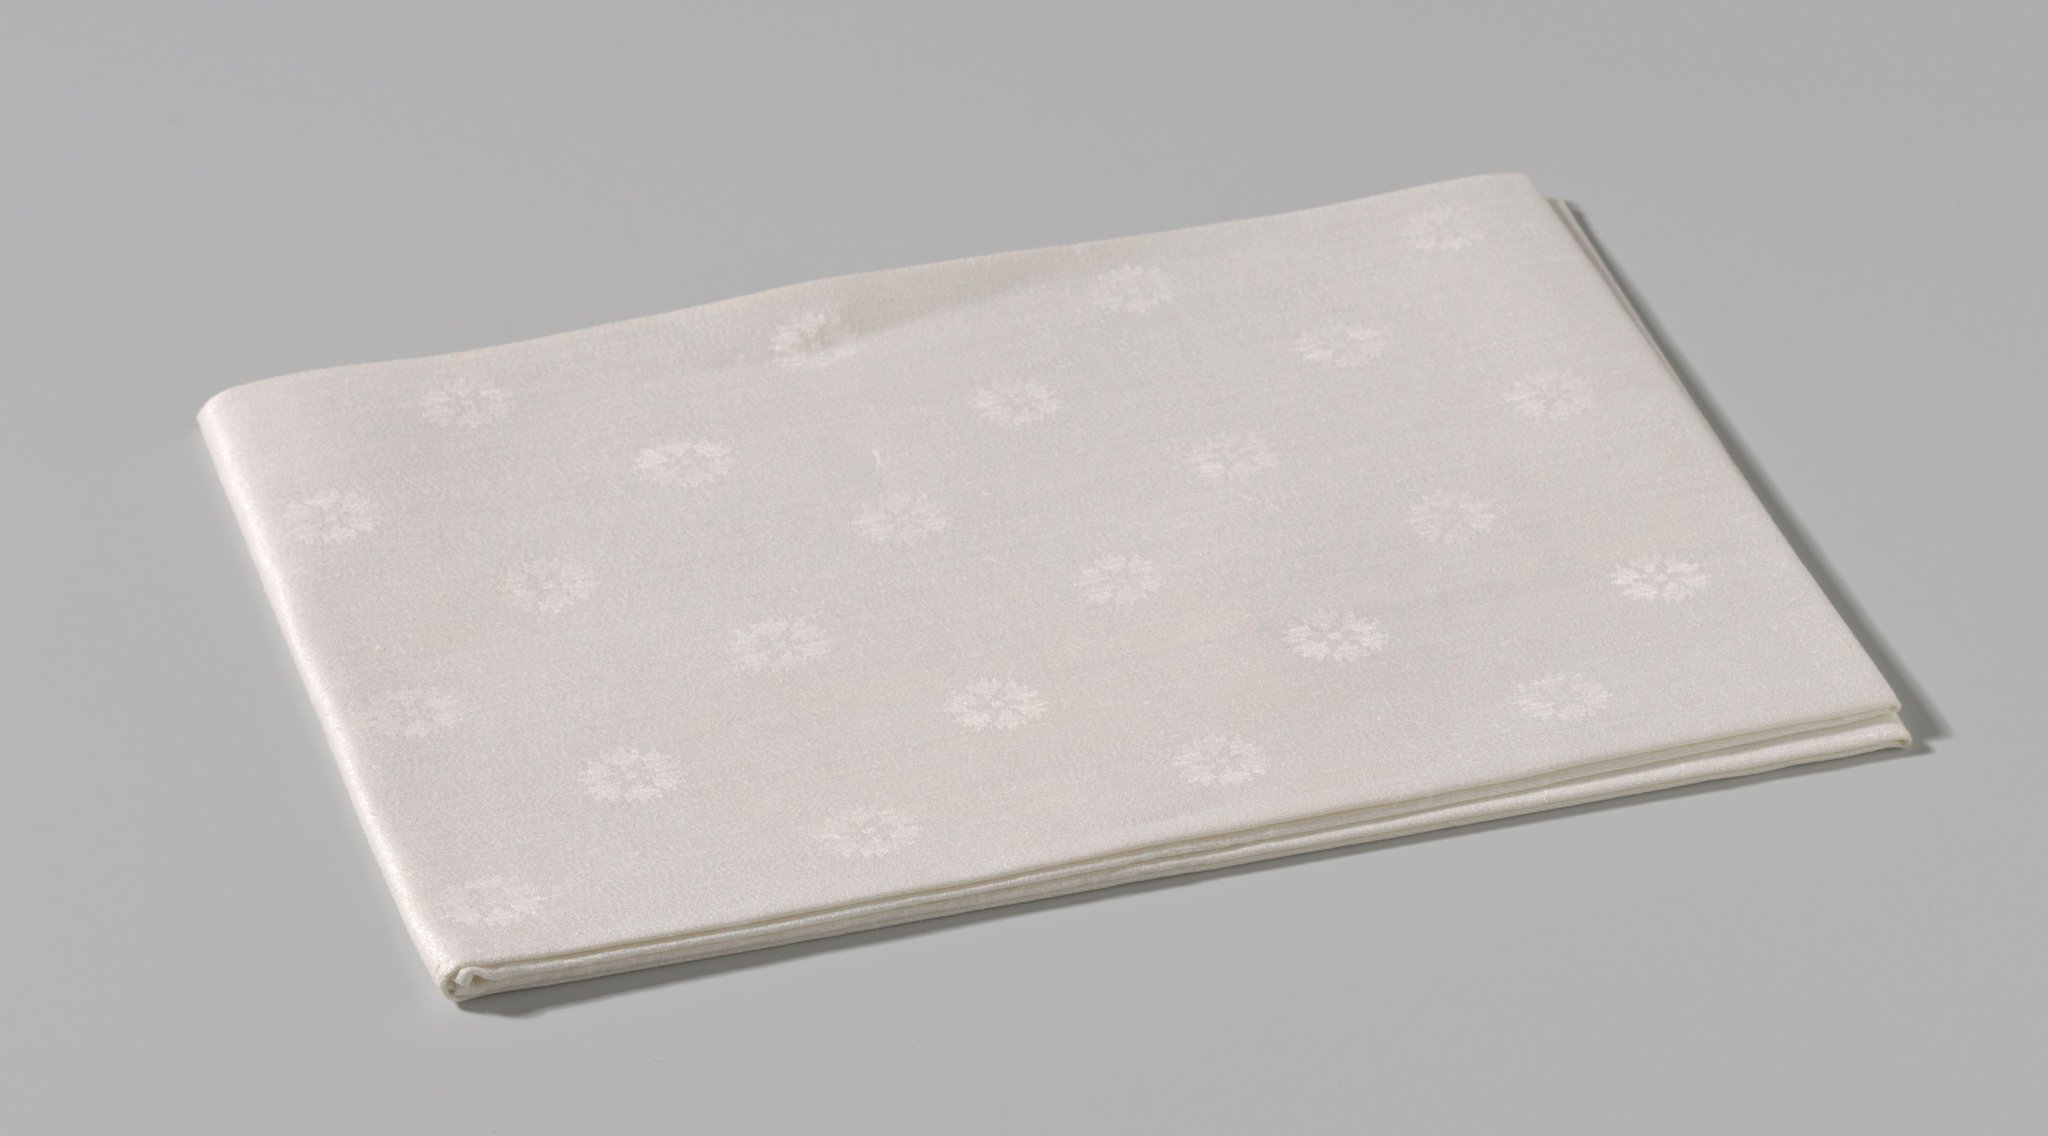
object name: napkin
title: Servet met een bloempatroon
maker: Anonymous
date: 1800-1810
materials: linen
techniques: damask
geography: western europe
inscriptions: mark: ‘ME’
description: Servet van linnendamast met een bloempatroon. Verspringende rijen van rozetten. Brede rand van spiraalsgewijs een middenstam omvattende tweezijdig gevederde bladranken. Vallend blaadje als vulling. Gelijke binnen- en buitenzoom van aaneengeschakelde cirkels. Rondom: blokkenrand. De bladranken van de servetten zijn niet identiek aan die van het tafellaken.